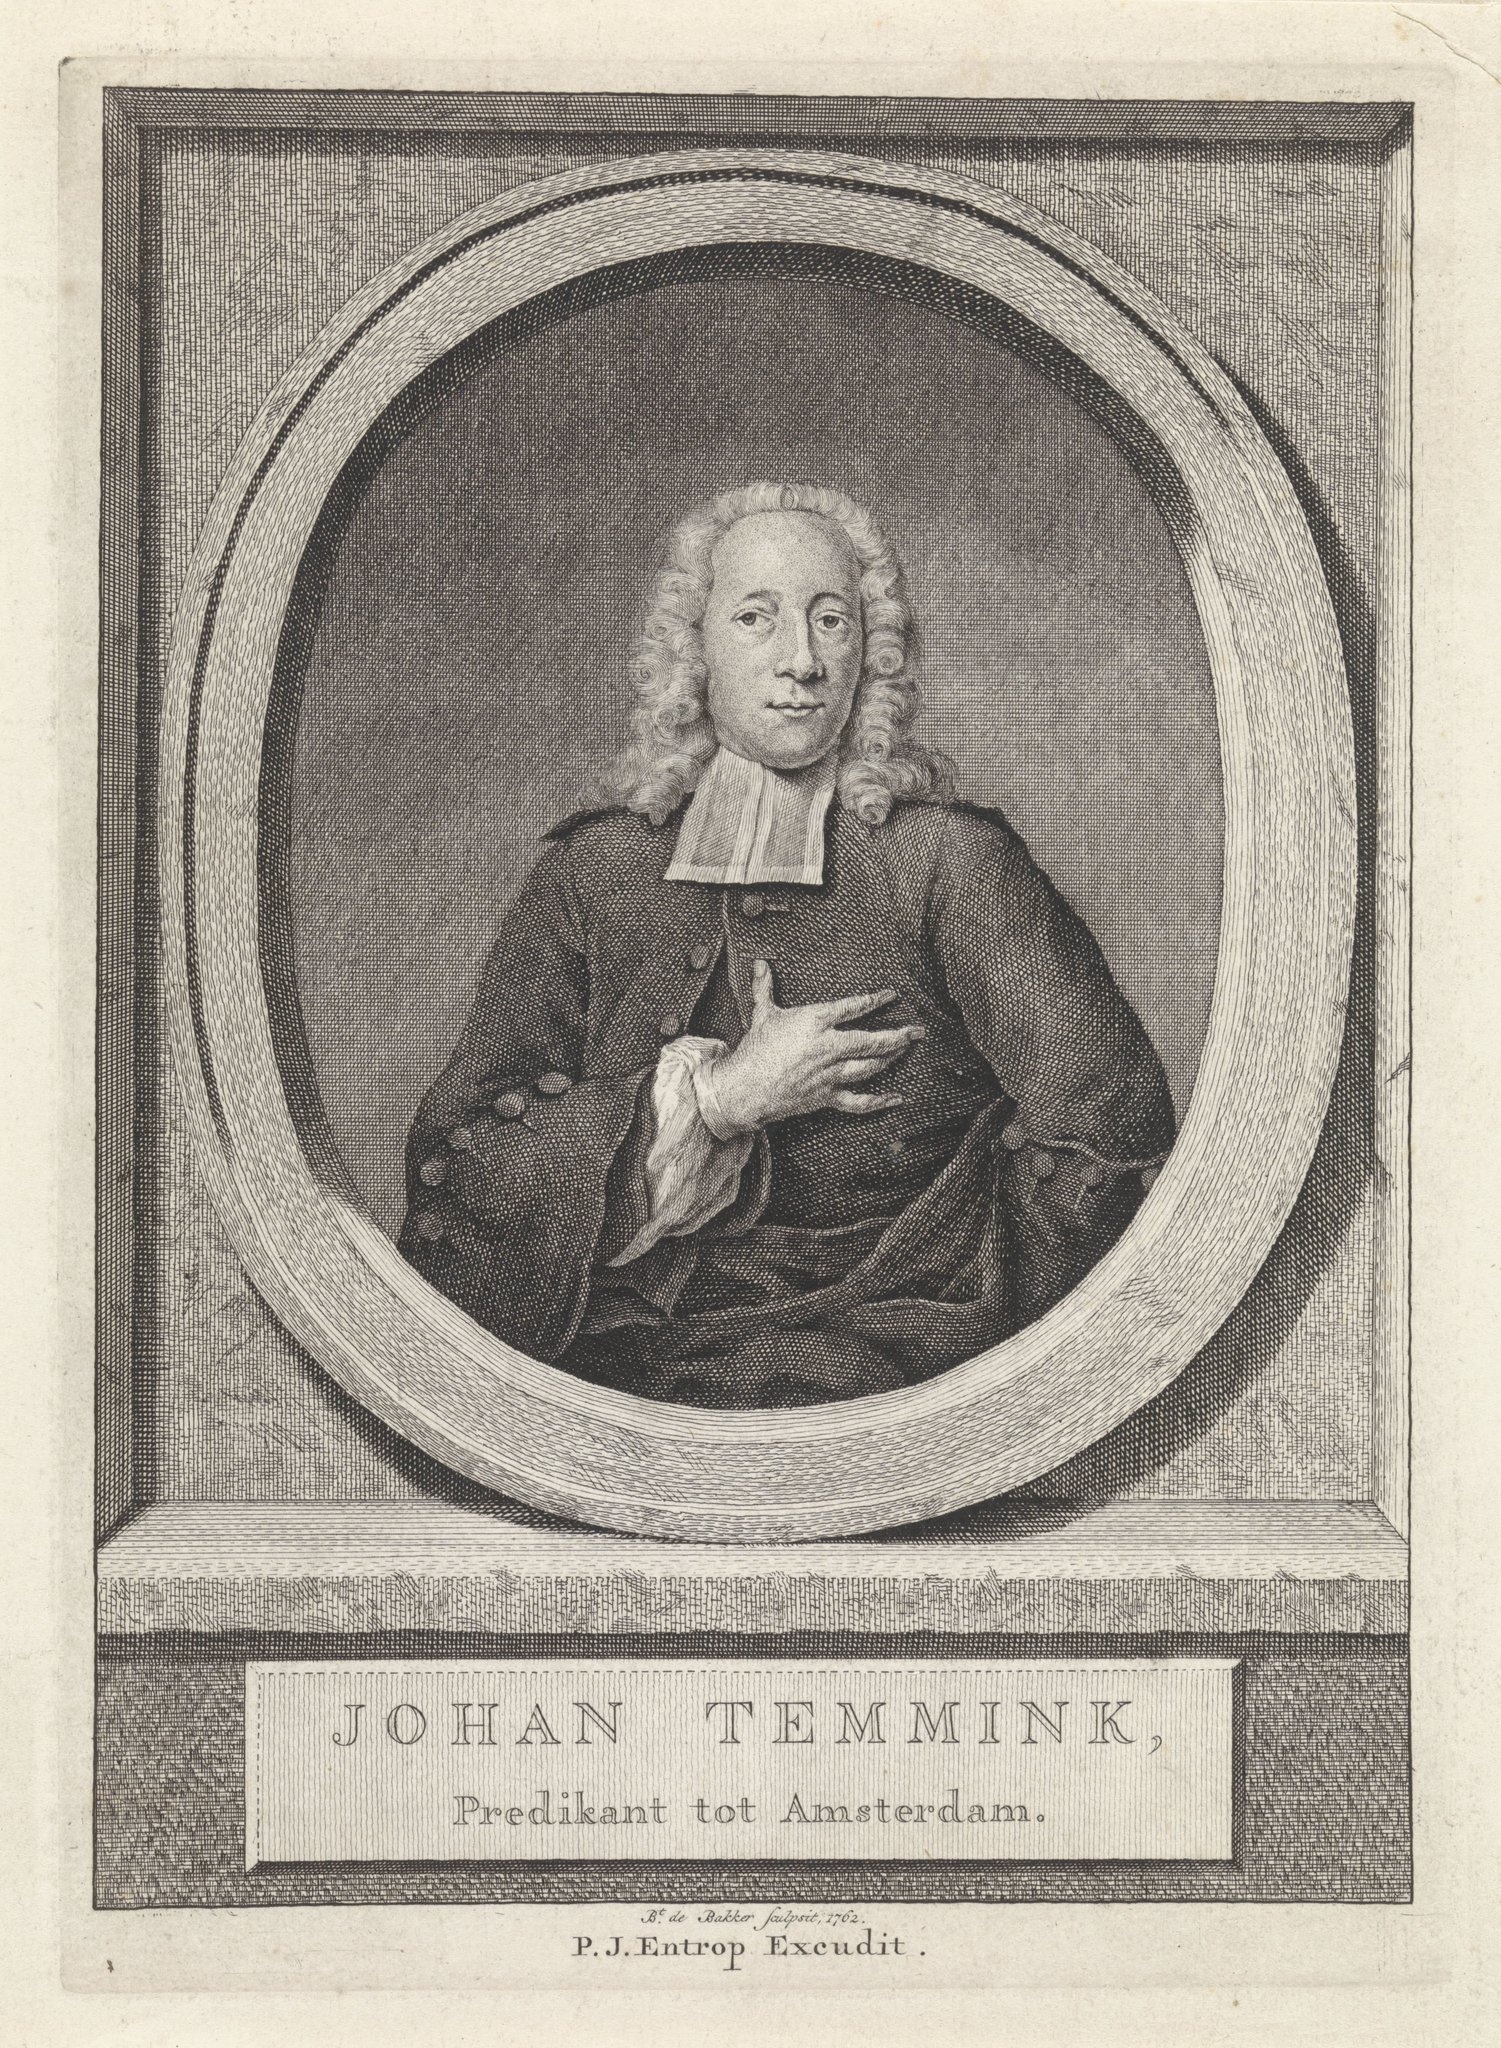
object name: print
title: Johan Temmink predikant tot Amsterdam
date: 1762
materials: paper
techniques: engraving, etching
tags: functionaries and dignitaries (with name) ~ episcopal protestant churches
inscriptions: collector's mark: Lugt 2228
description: Vergelijk prent met vergelijkbaar portret in collectie Stadsarchief Amsterdam door C.F. Fritsch naar tekening van Jacob van der Schley. Mogelijk maakte Barent de Bakker gebruik van dezelfde tekening.